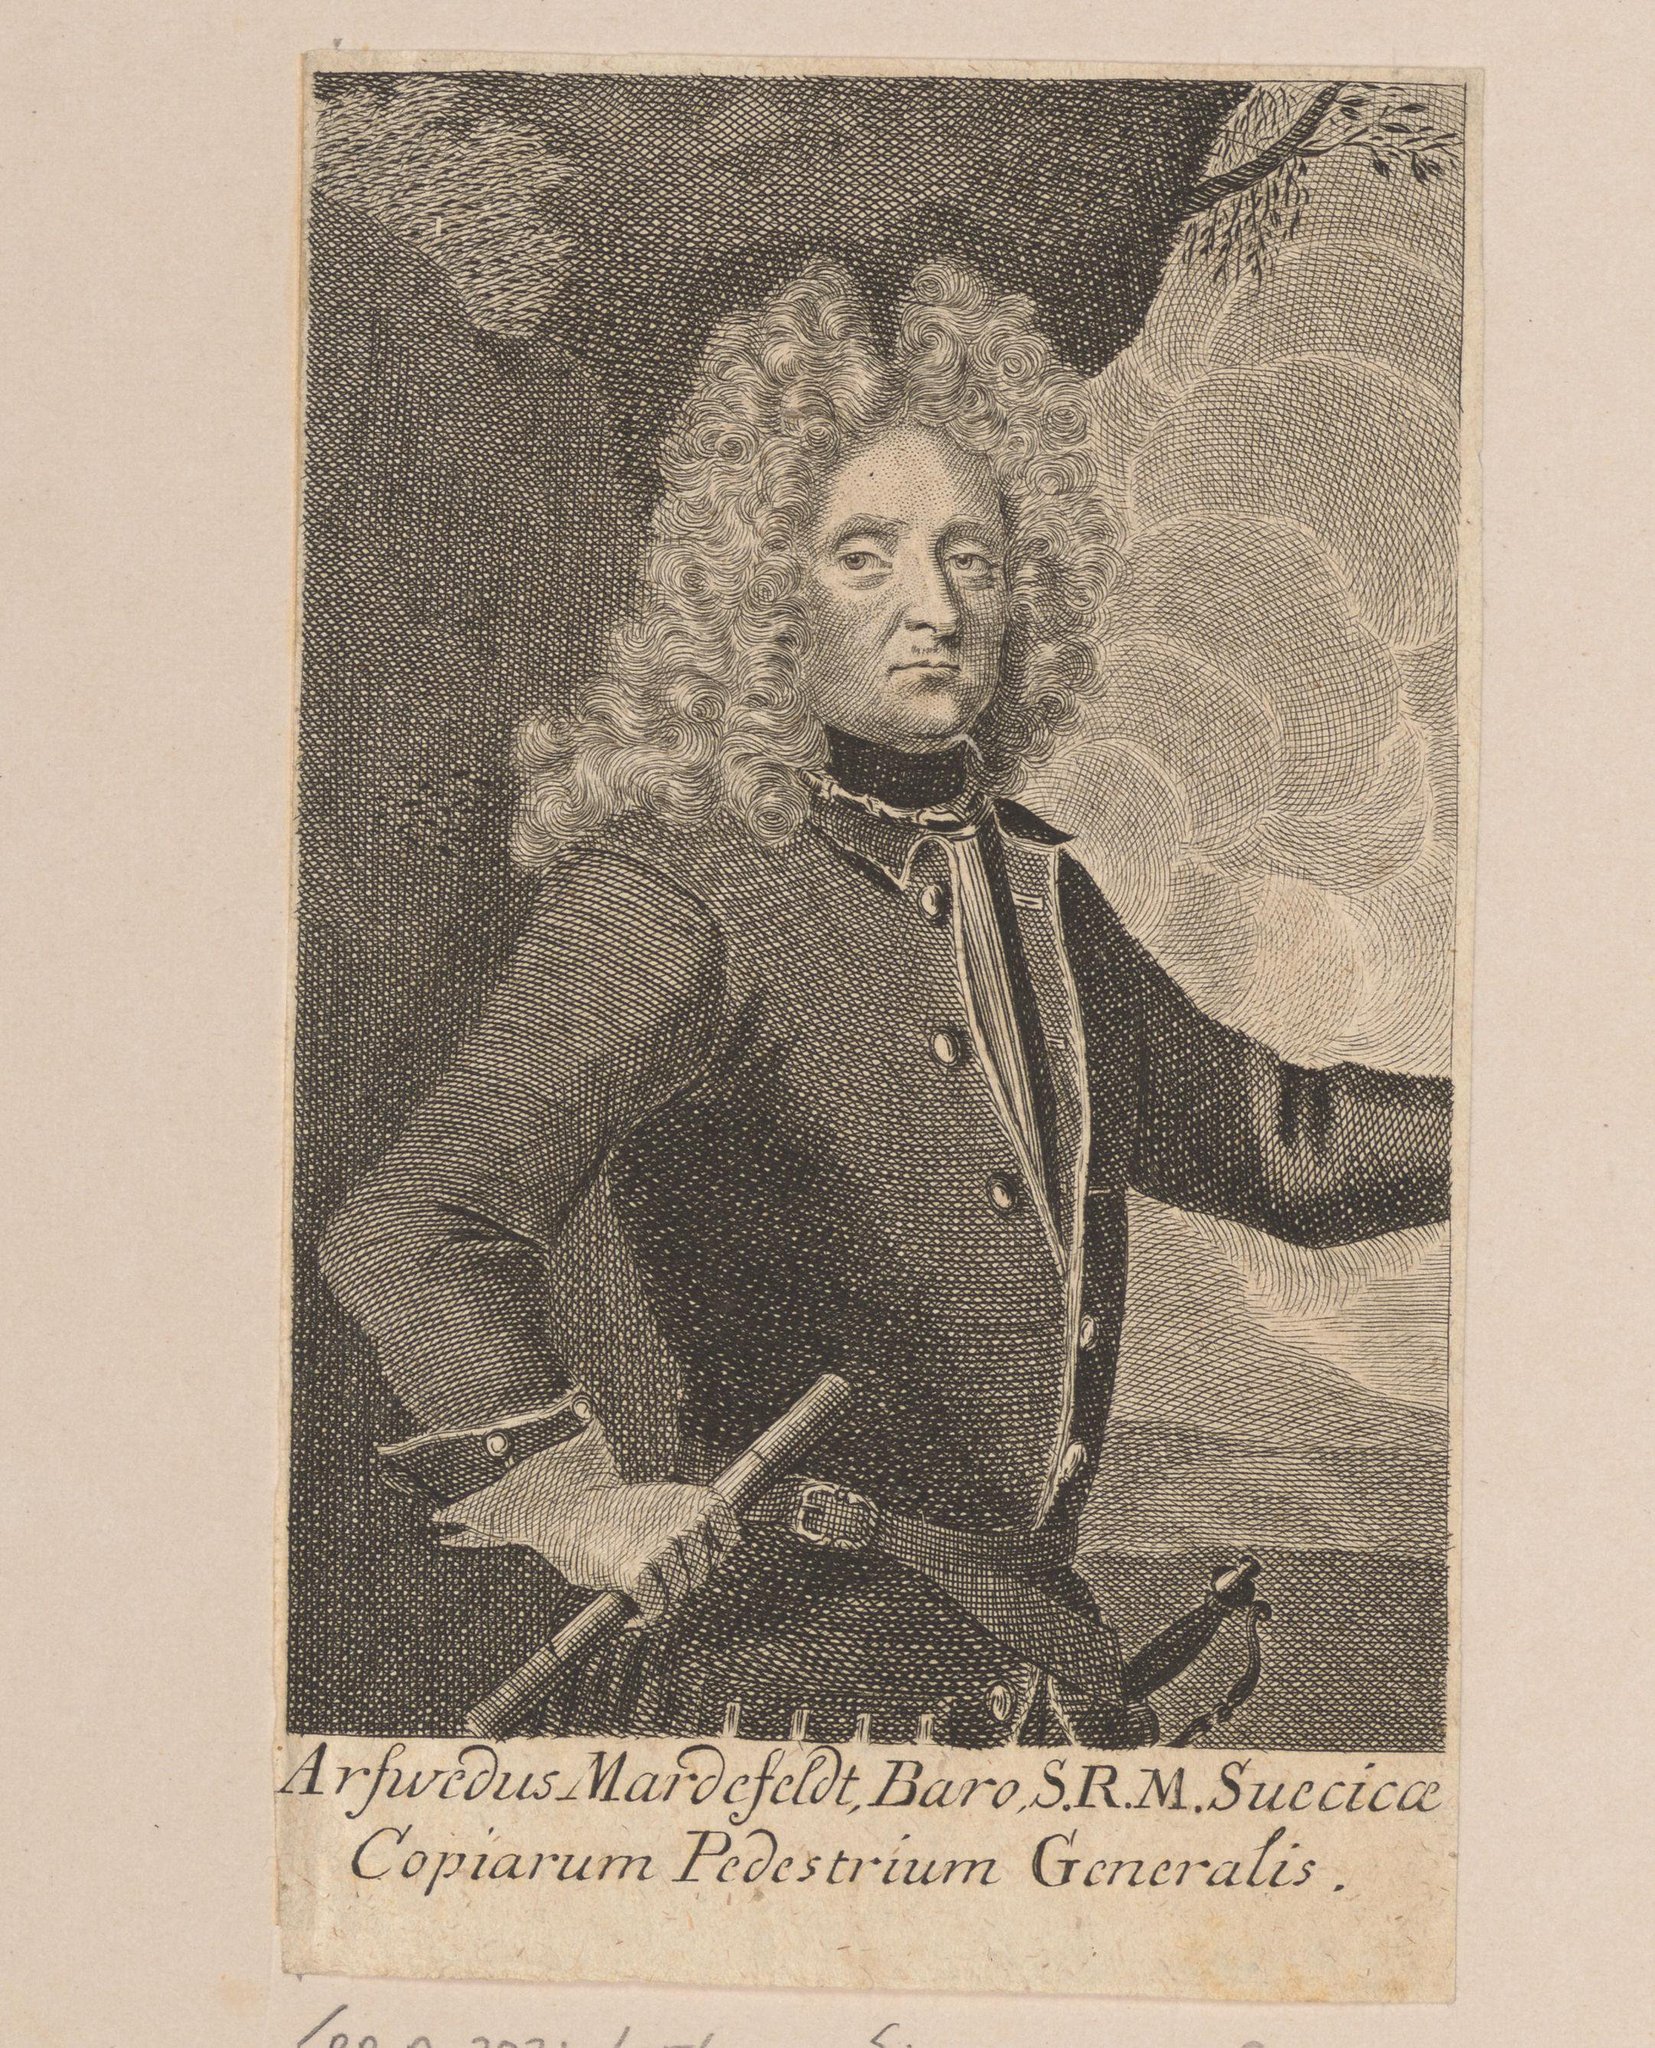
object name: print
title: Portret van Arvid Axel Mardefelt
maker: martin bernigeroth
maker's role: print maker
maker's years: 1670-1733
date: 1707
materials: paper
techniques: engraving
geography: germany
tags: commander-in-chief, general, marshal, historical persons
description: Prent waarschijnlijk uit: Die Europäische Fama, Welche den gegenwärtigen Zustand der vornehmsten Höfe entdecket (1707), dl. 62.